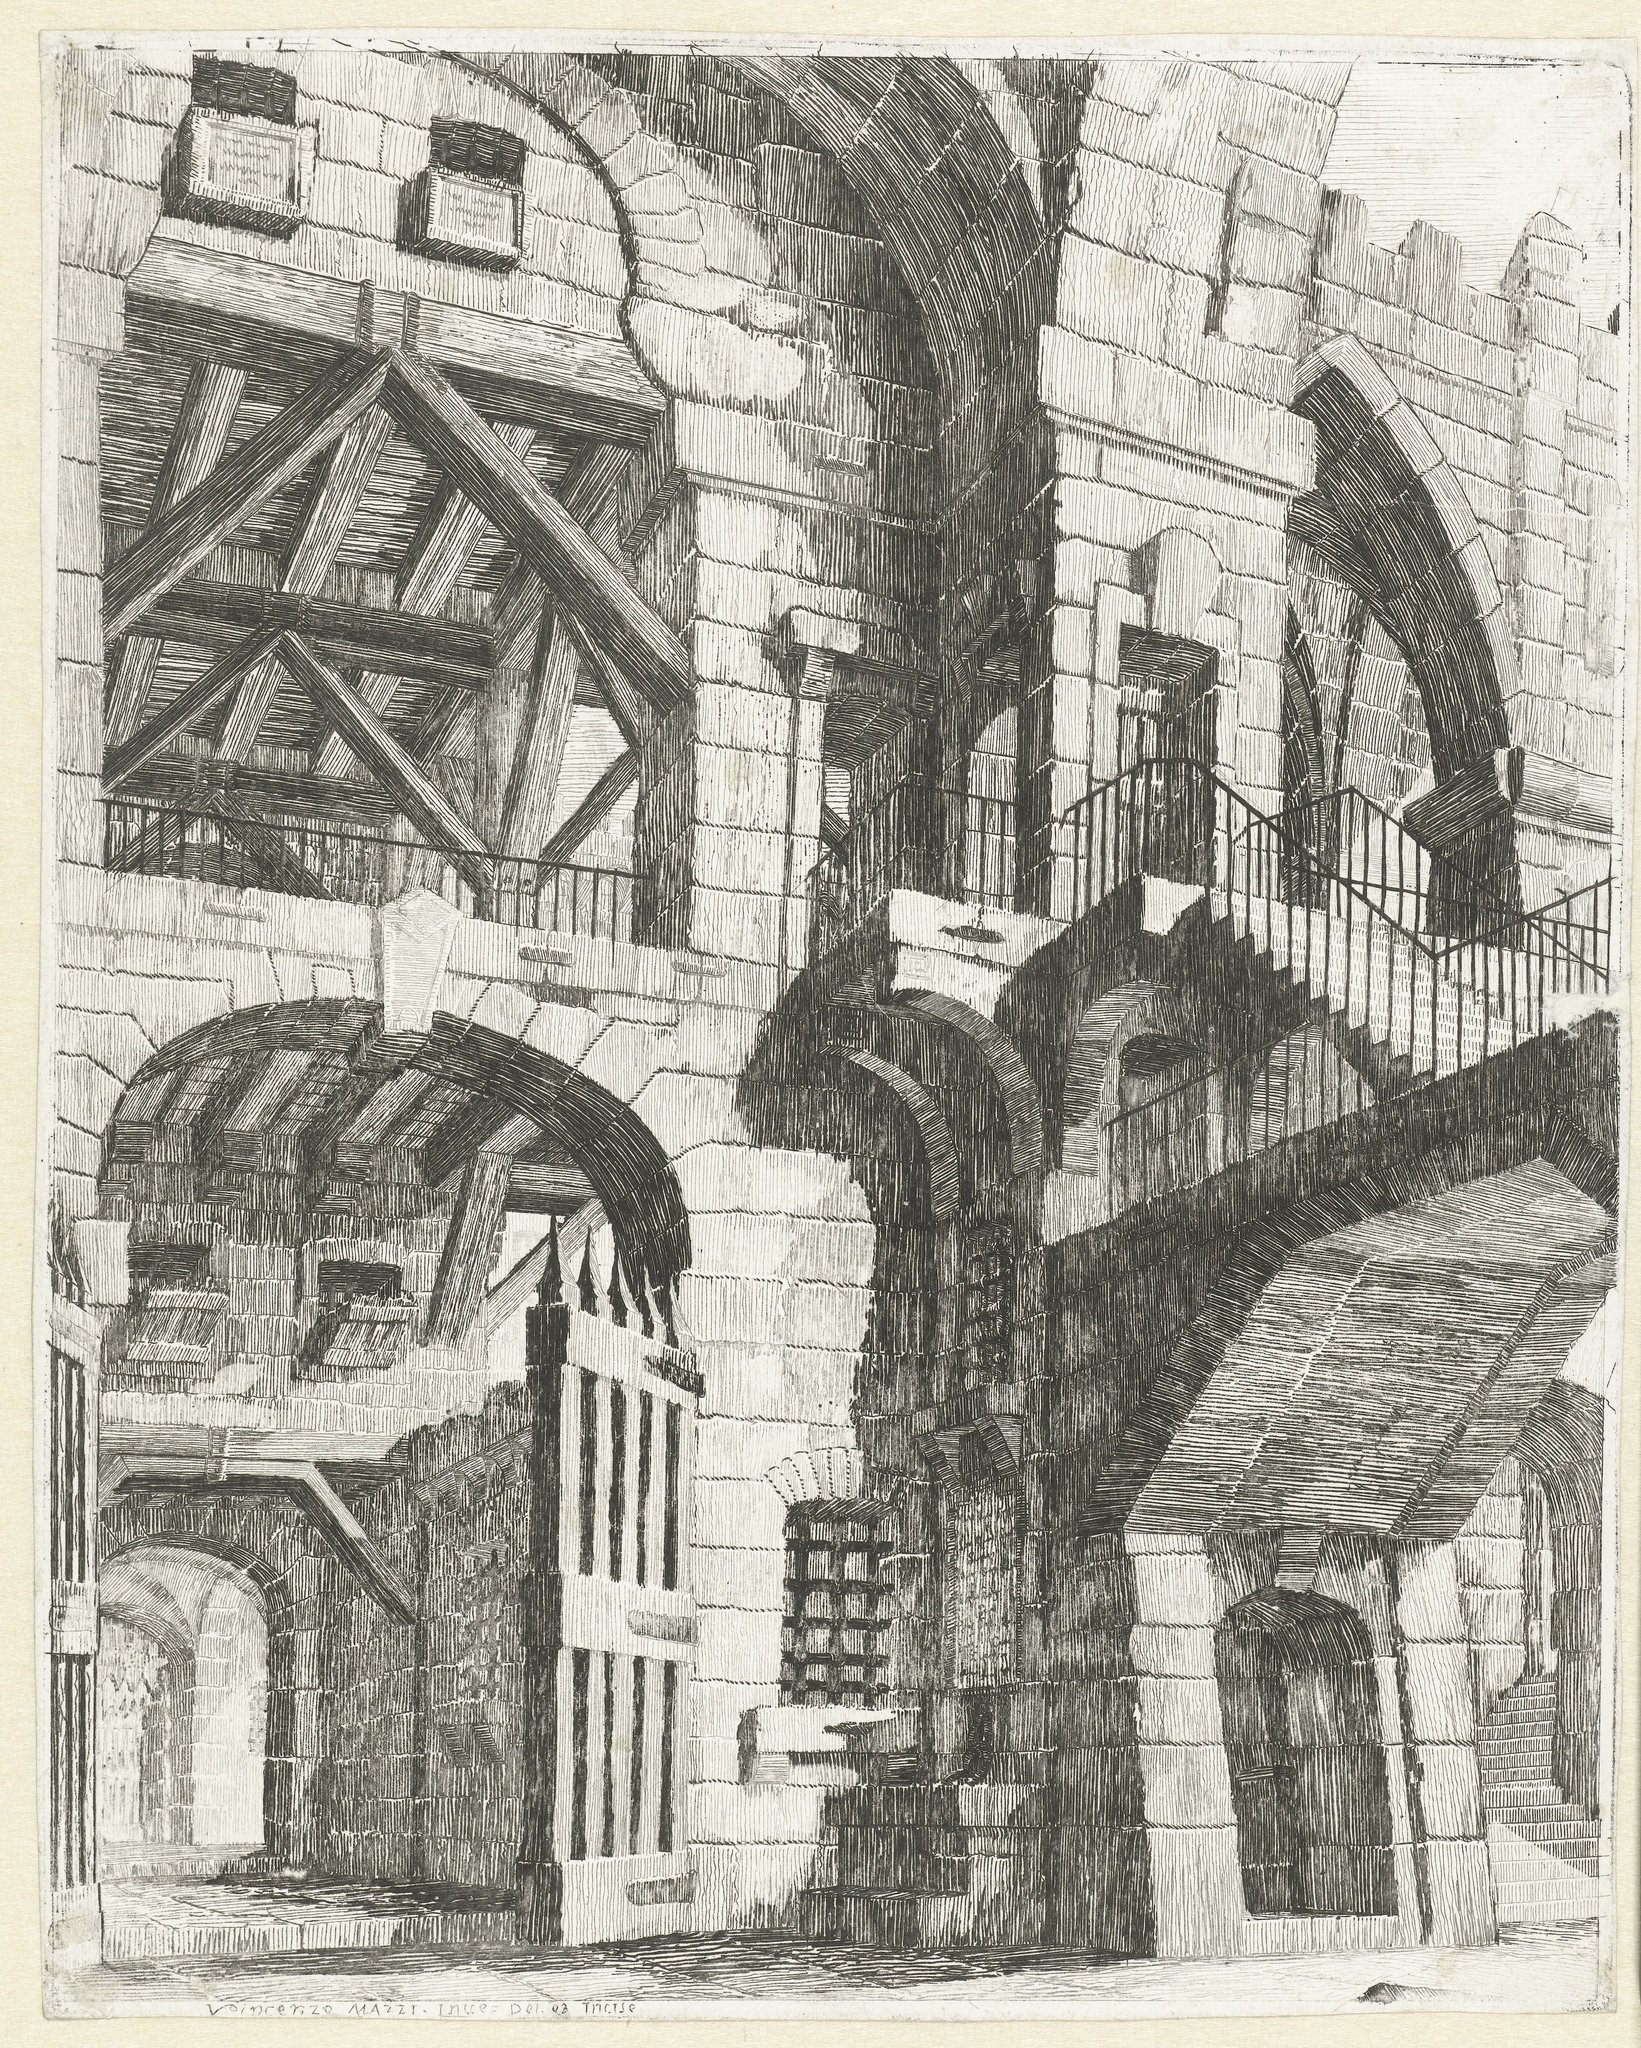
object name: print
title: Caprici di Scene Teatrali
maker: vincenzo mazzi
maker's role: print maker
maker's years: 1748-1790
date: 1771-1781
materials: paper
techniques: etching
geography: italy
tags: architectural folly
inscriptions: collector's mark: Lugt 2760, collector's mark: Lugt 2228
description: Fantasiearchitectuur bestaande uit een binnenplaats met in het midden een houten poort die toegang geeft tot een ruimte met houten zoldering. Prent uit een serie van twaalf met voorbeelden voor theaterdecors.